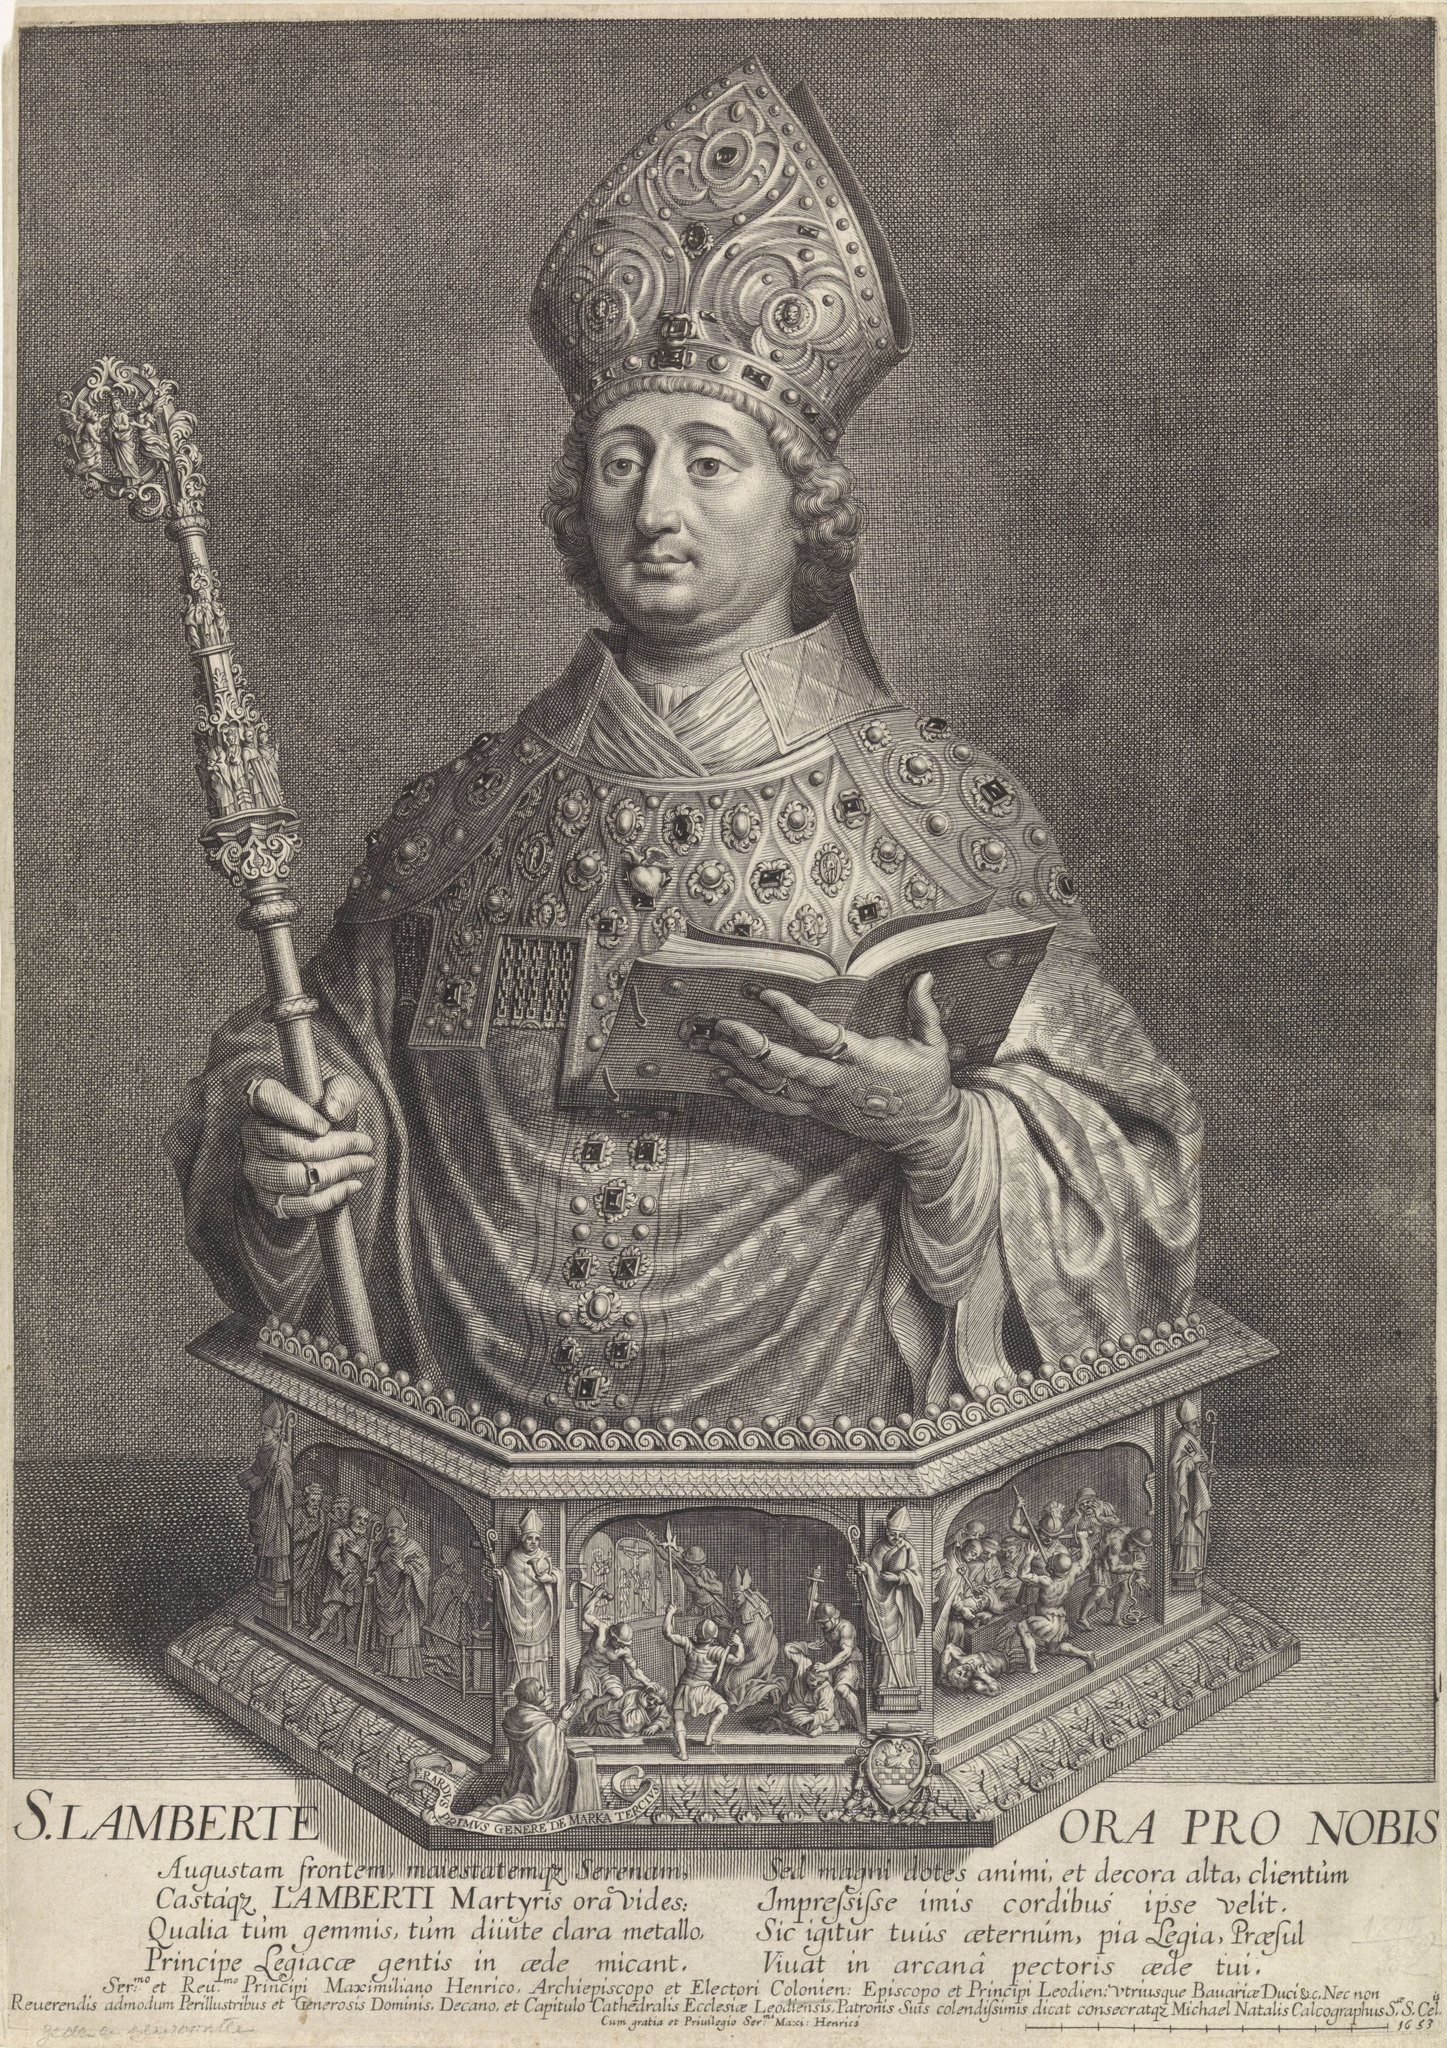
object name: print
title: Reliekbuste van de heilige Lambertus van Maastricht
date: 1653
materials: paper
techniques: engraving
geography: liège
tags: lambert(us), martyr bishop of maastricht and patron of liège; possible attributes: arrow, bear, cloth with flames, lance, nobleman under crozier, rationale, sword, two armed men under feet, relics (and reliquaries), liège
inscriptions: collector's mark: Lugt 2228, collector's mark: Lugt 3418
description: De reliekbuste van de heilige Lambertus van Maastricht te Luik ingelegd met edelstenen. De buste toont Lambertus met staf en boek, een mijter op zijn hoofd. Op het pedestal drie scènes uit het leven van de heilige Lambertus, de middelste scène toont zijn dood. Onderaan in de marge twee vierregelige teksten in het Latijn.